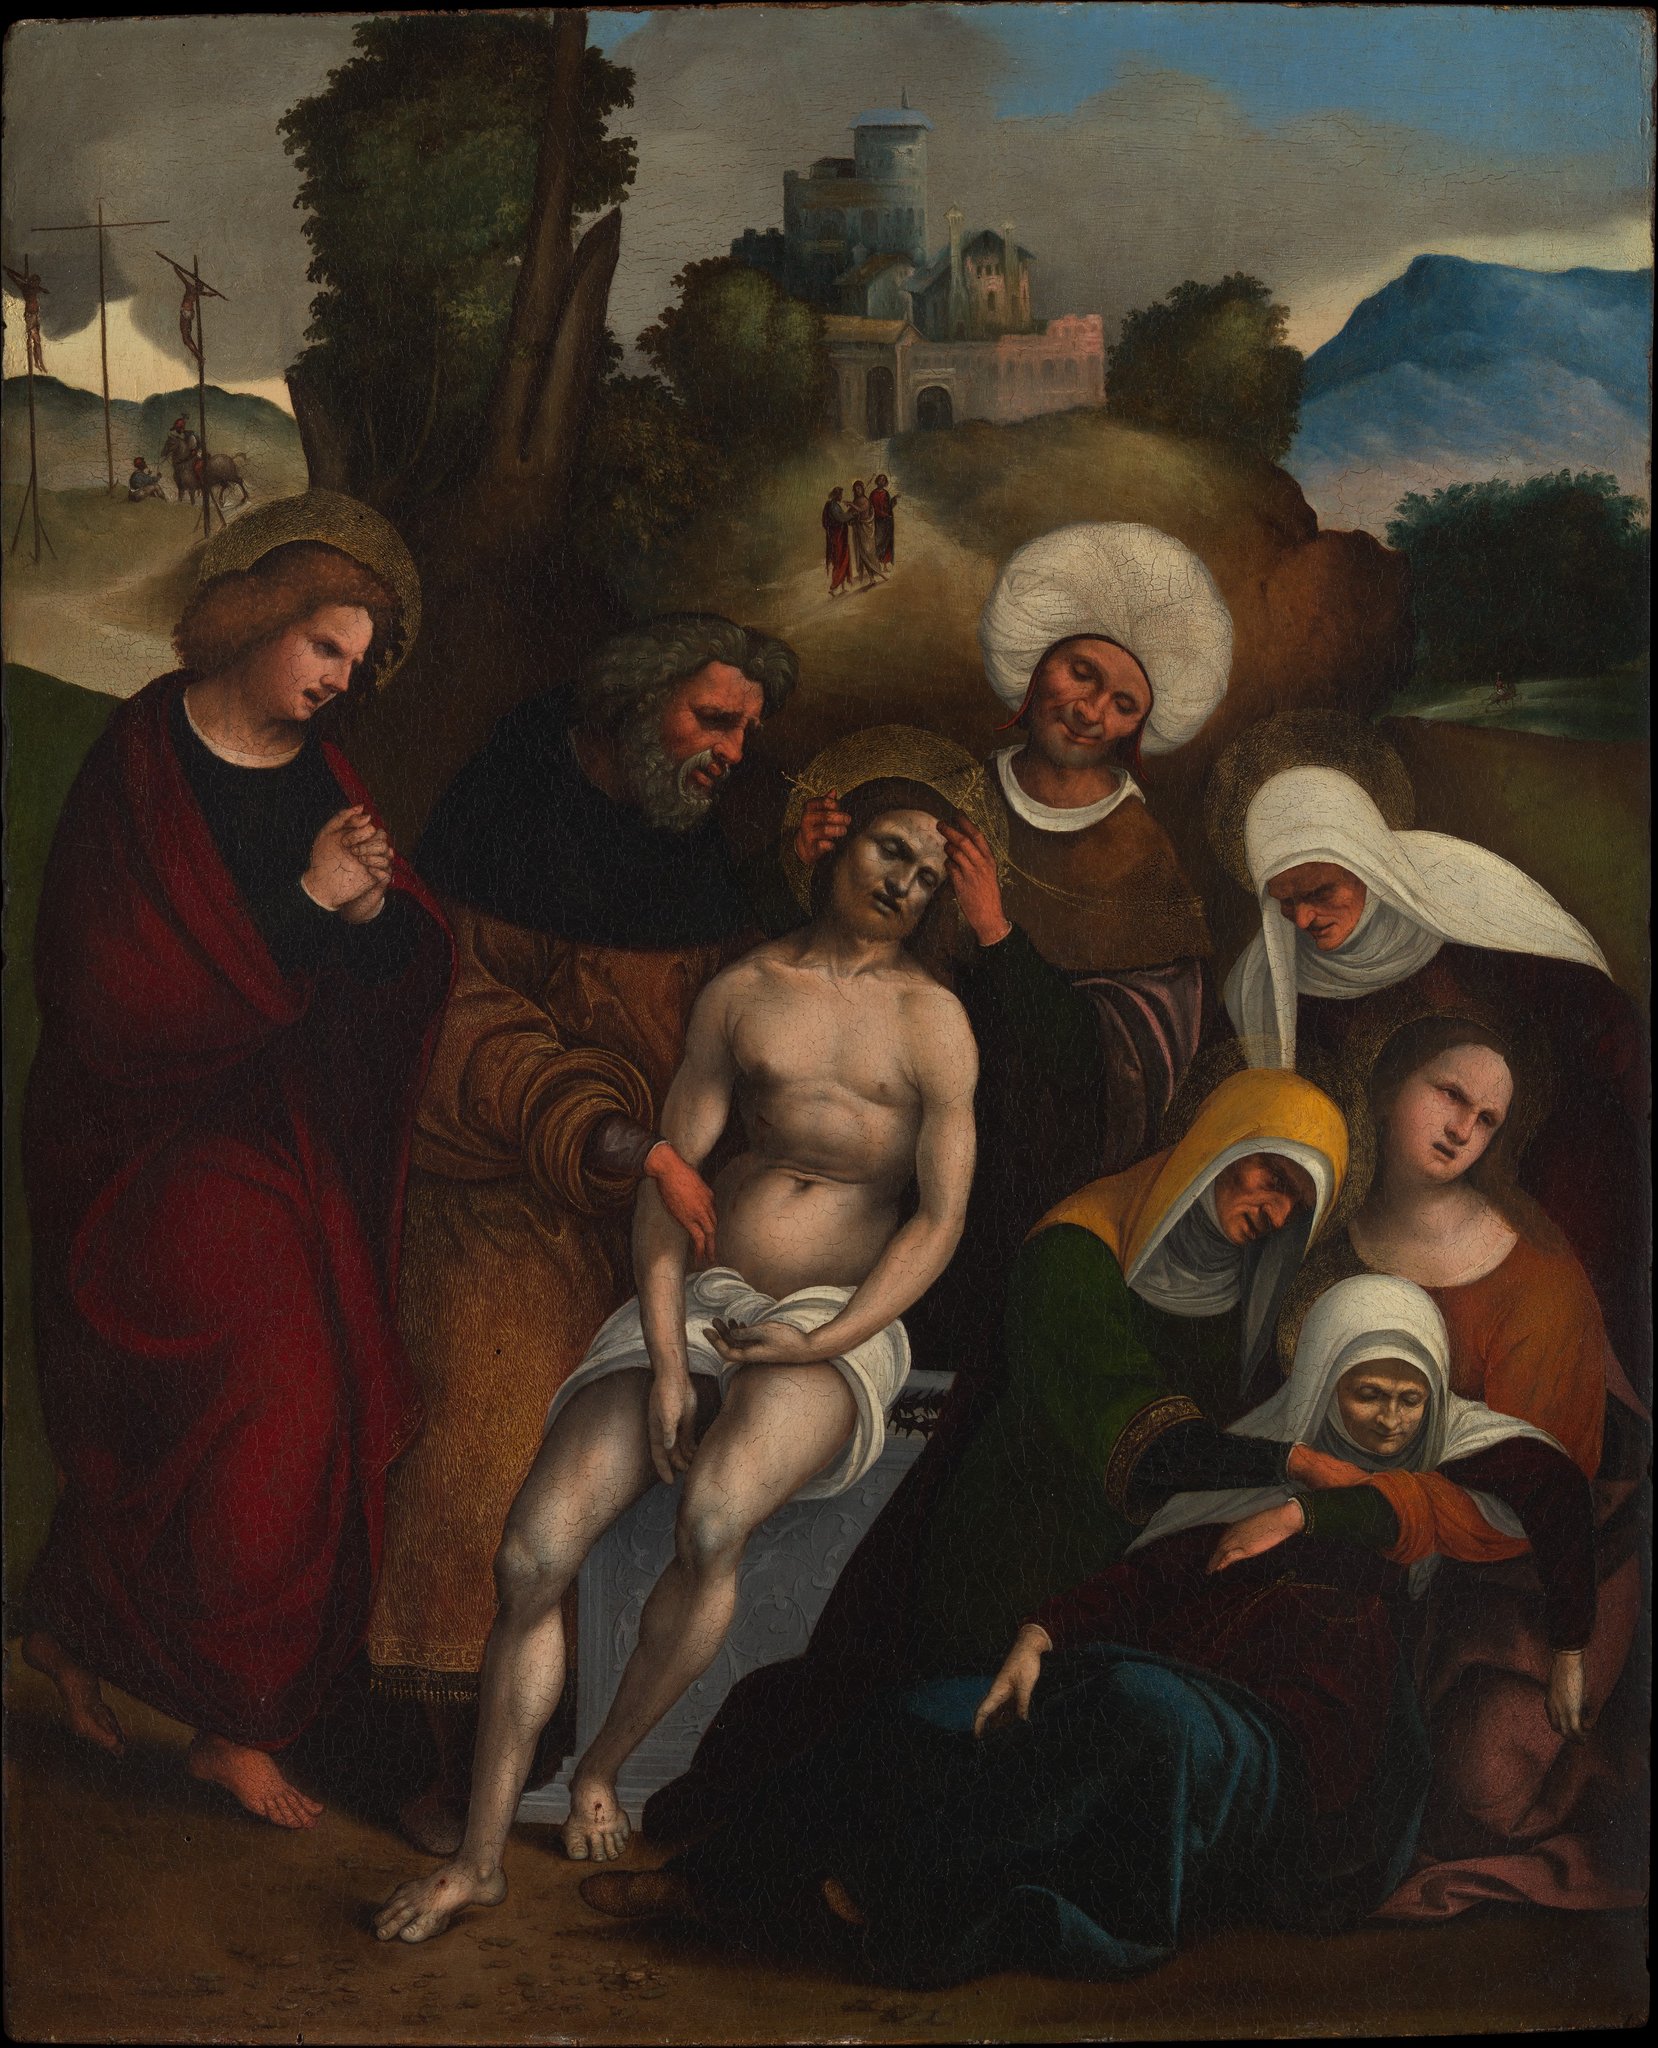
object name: painting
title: The Lamentation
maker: ludovico mazzolino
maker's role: artist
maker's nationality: italian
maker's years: 1480-1528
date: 1514-1516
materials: oil, wood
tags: men,women,christ,saint john the evangelist,virgin mary,lamentation